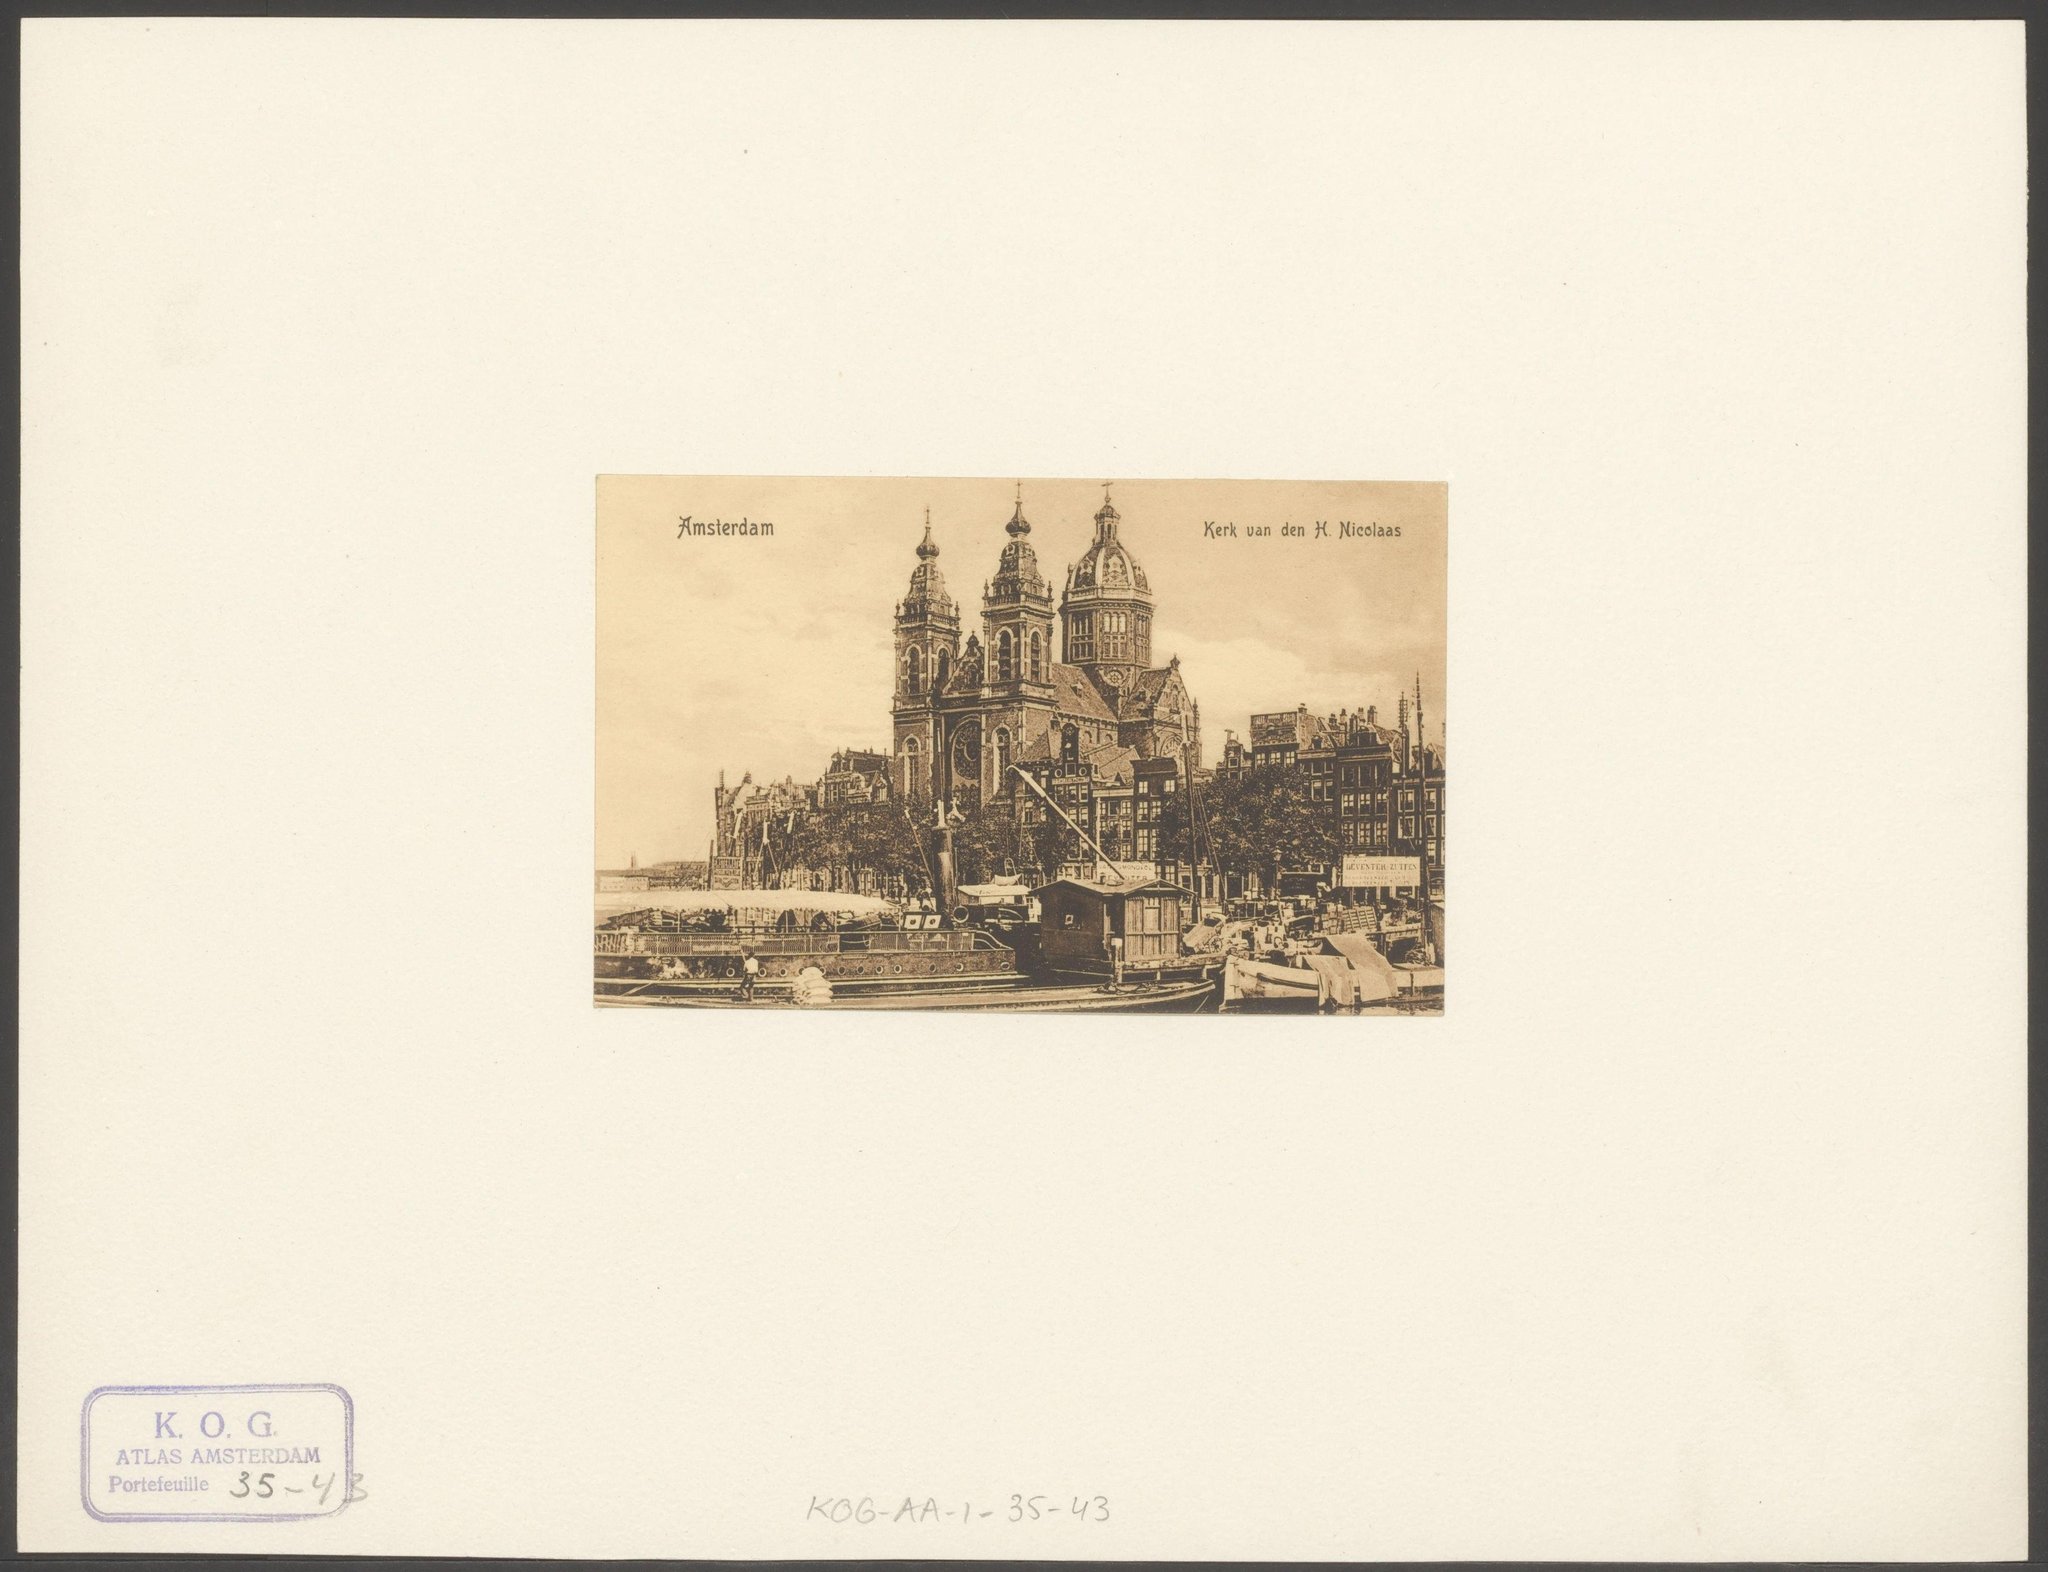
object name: photograph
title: Amsterdam Kerk van den H. Nicolaas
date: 1910-1912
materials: cardboard, paper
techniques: albumen print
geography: amsterdam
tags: harbour, city-view in general; 'veduta', roman catholic church, parts of church exterior and annexes: façade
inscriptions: collector's mark: ‘35-43’ Lugt 1641b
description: Onderwerpsrubriek binnen de Atlas Amsterdam: R.K. Gemeenten: Sint Nicolaaskerk t/m Willibrordus (Rustenburgerstraat).